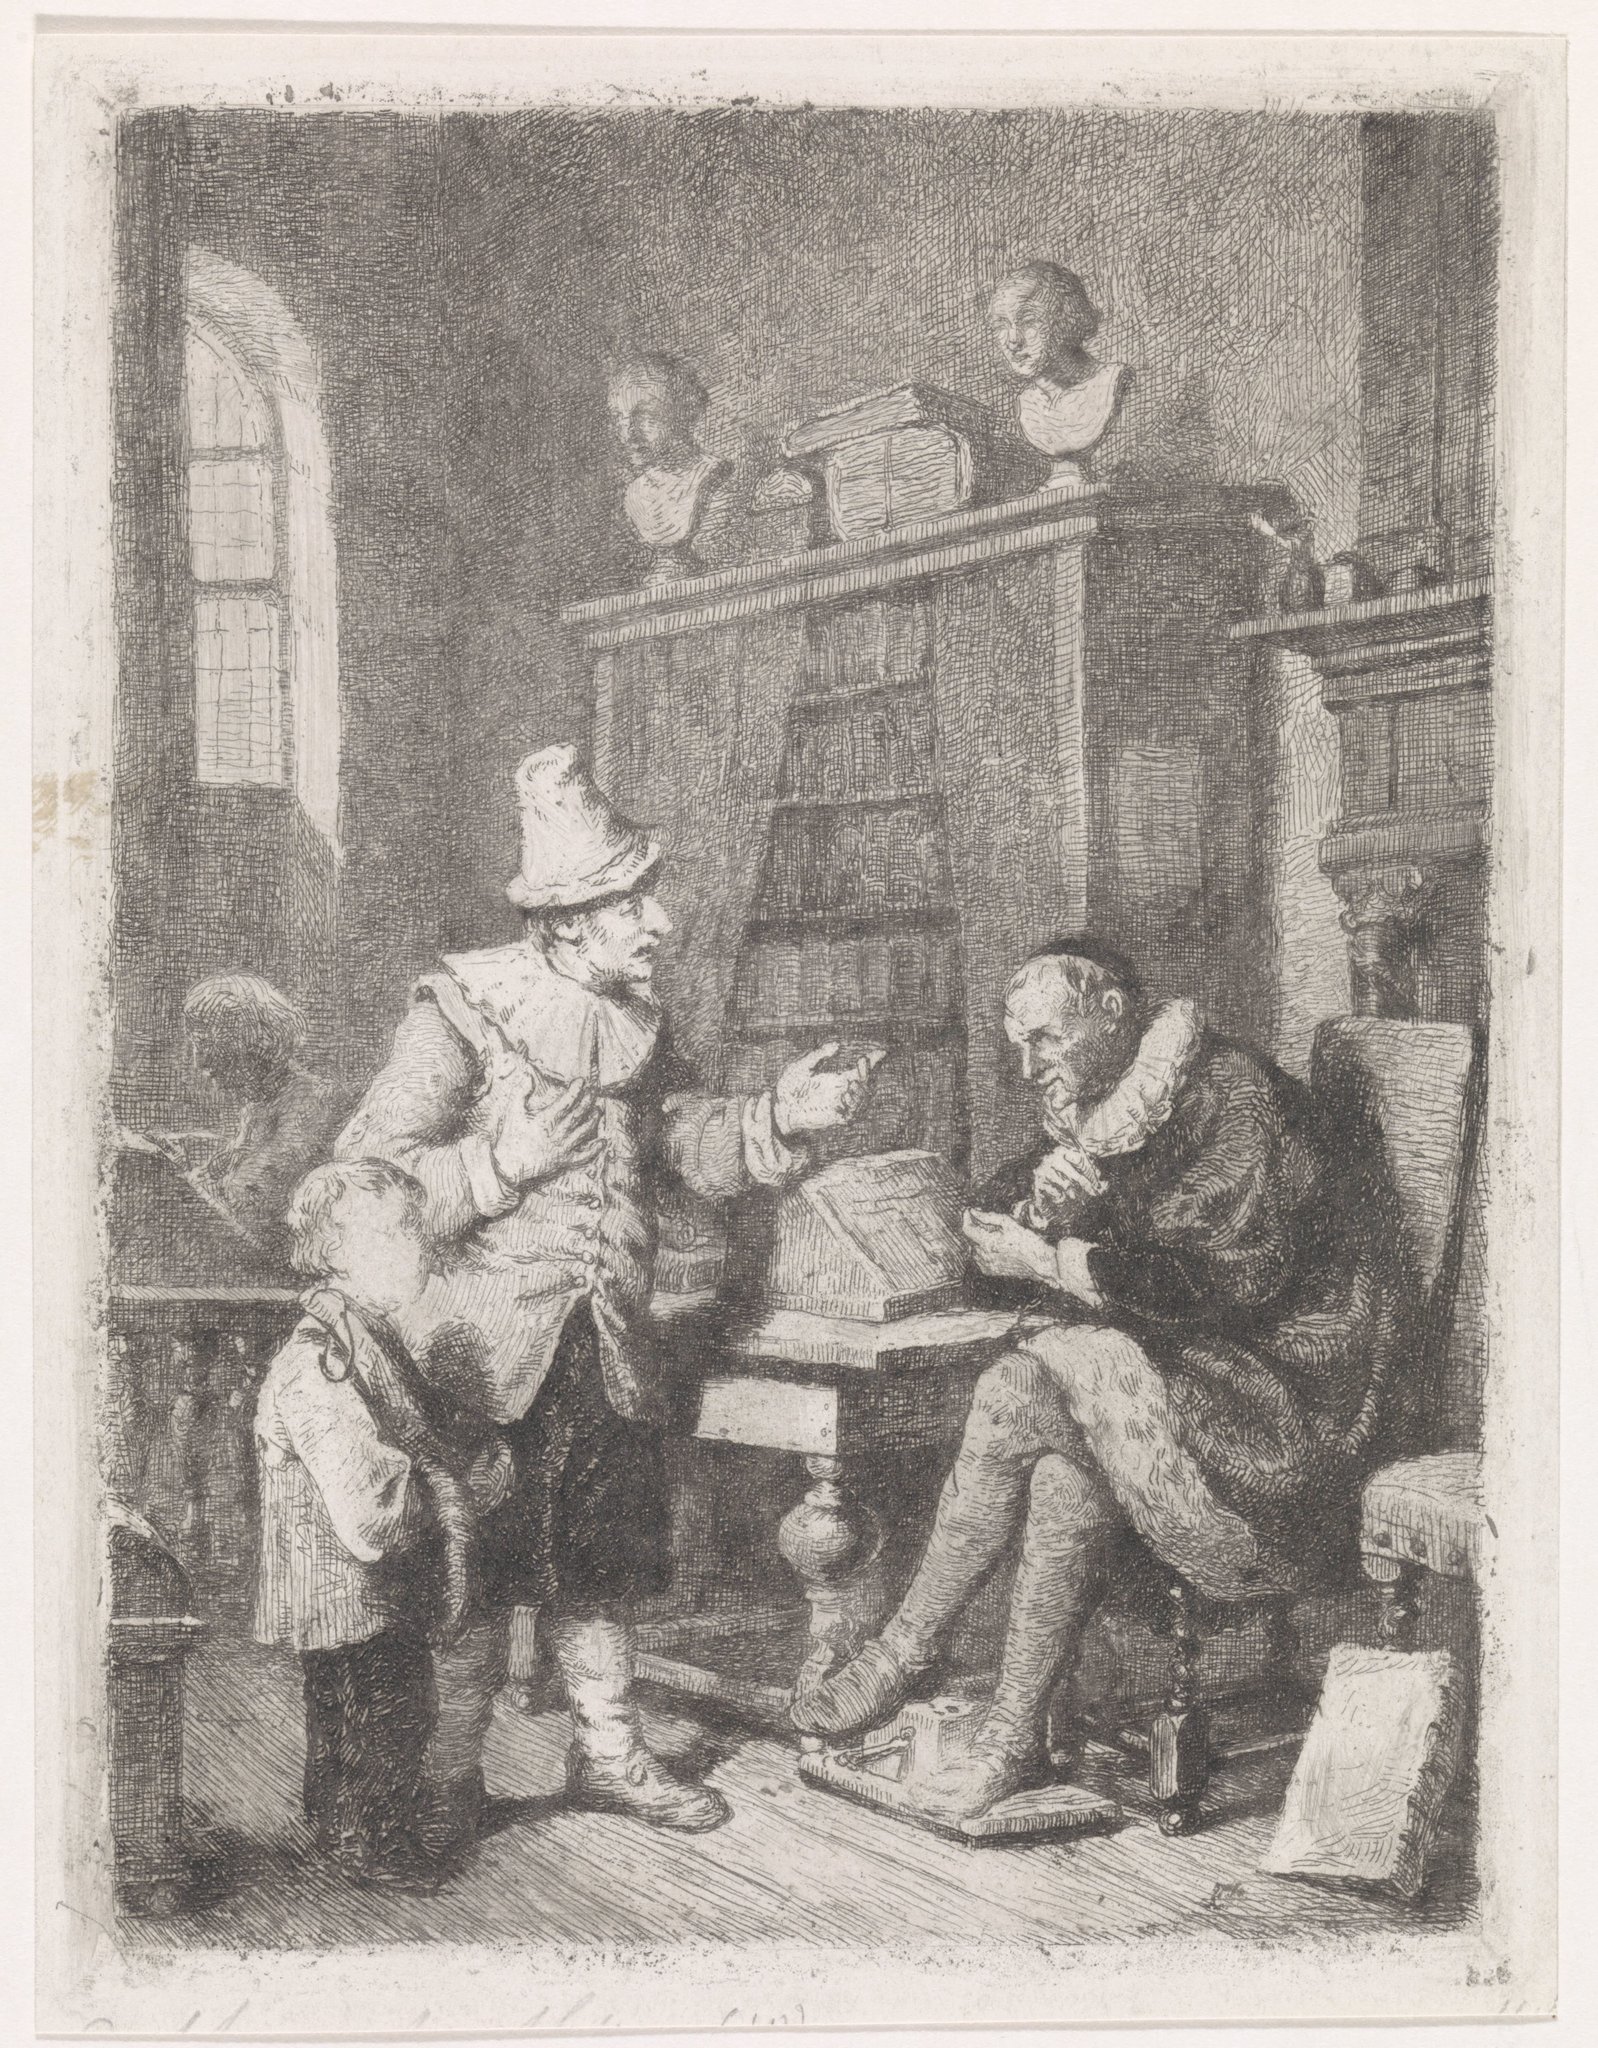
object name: print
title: Bij de advocaat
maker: david van der kellen (1827-1895)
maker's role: draughtsman, print maker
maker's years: 1827-1895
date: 1837-1882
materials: paper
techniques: drypoint, etching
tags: lawyer, attorney at law, sausage, ham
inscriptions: collector's mark: Lugt 2228, inscription: ‘de neus het (...) Molkenb’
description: In een vertrek zit een rijkelijk geklede advocaat voor de schouw bij een lessenaar, waarvoor een gebarende man met hoed staat. Bij de man staat een jongetje dat een ham en worst bij zich heeft. De man vraagt mogelijk raad aan de advocaat, die de man met een handgebaar duidelijk maakt dat raad geld kost. Op de achtergrond staat een boekenkast met daarop twee bustes en achter een hekje is het silhouet van een figuur bij een lessenaar zichtbaar. De neus, het rechteroog en de mouw van het jongetje zijn geheel uitgeslepen, zodat er slechts een klein gedeelte van de beschaduwde wang en van het voorhoofd zichtbaar is.